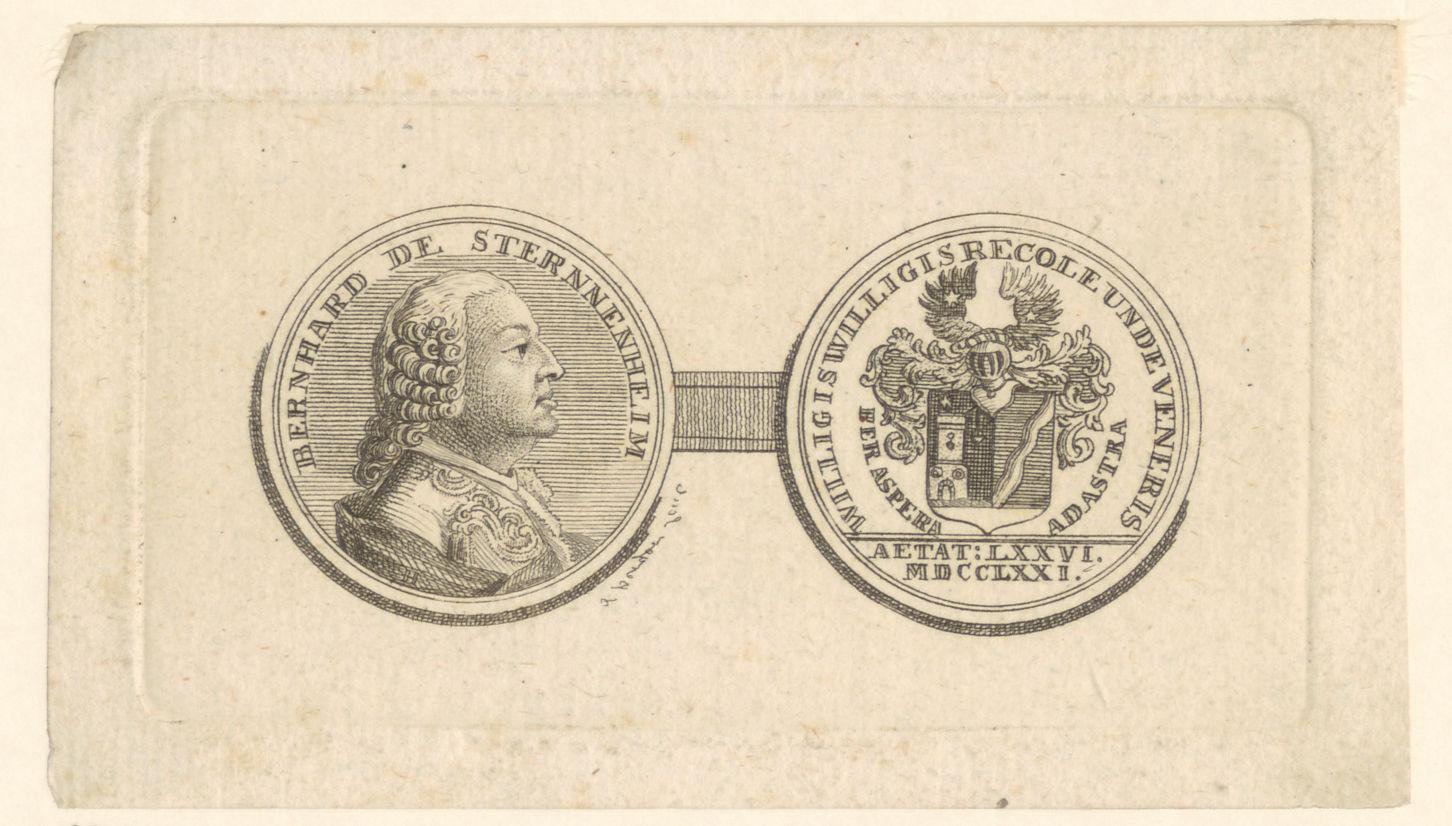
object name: print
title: Medaille met een portret van Bernhard Winkler von Sternnenheim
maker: daniel berger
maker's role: print maker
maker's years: 1744-1824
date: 1773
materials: paper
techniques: etching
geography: berlin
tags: historical persons, armorial bearing, heraldry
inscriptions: collector's mark: Lugt 2228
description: Prent ook gebruikt in: Möhsen, Johann Karl Wilhelm. Beschreibung einer Berlinischen Medaillen-Sammlung. Dl. 1. Berlijn en Leipzig: Georg Jacob Decker, 1773, p. 418.